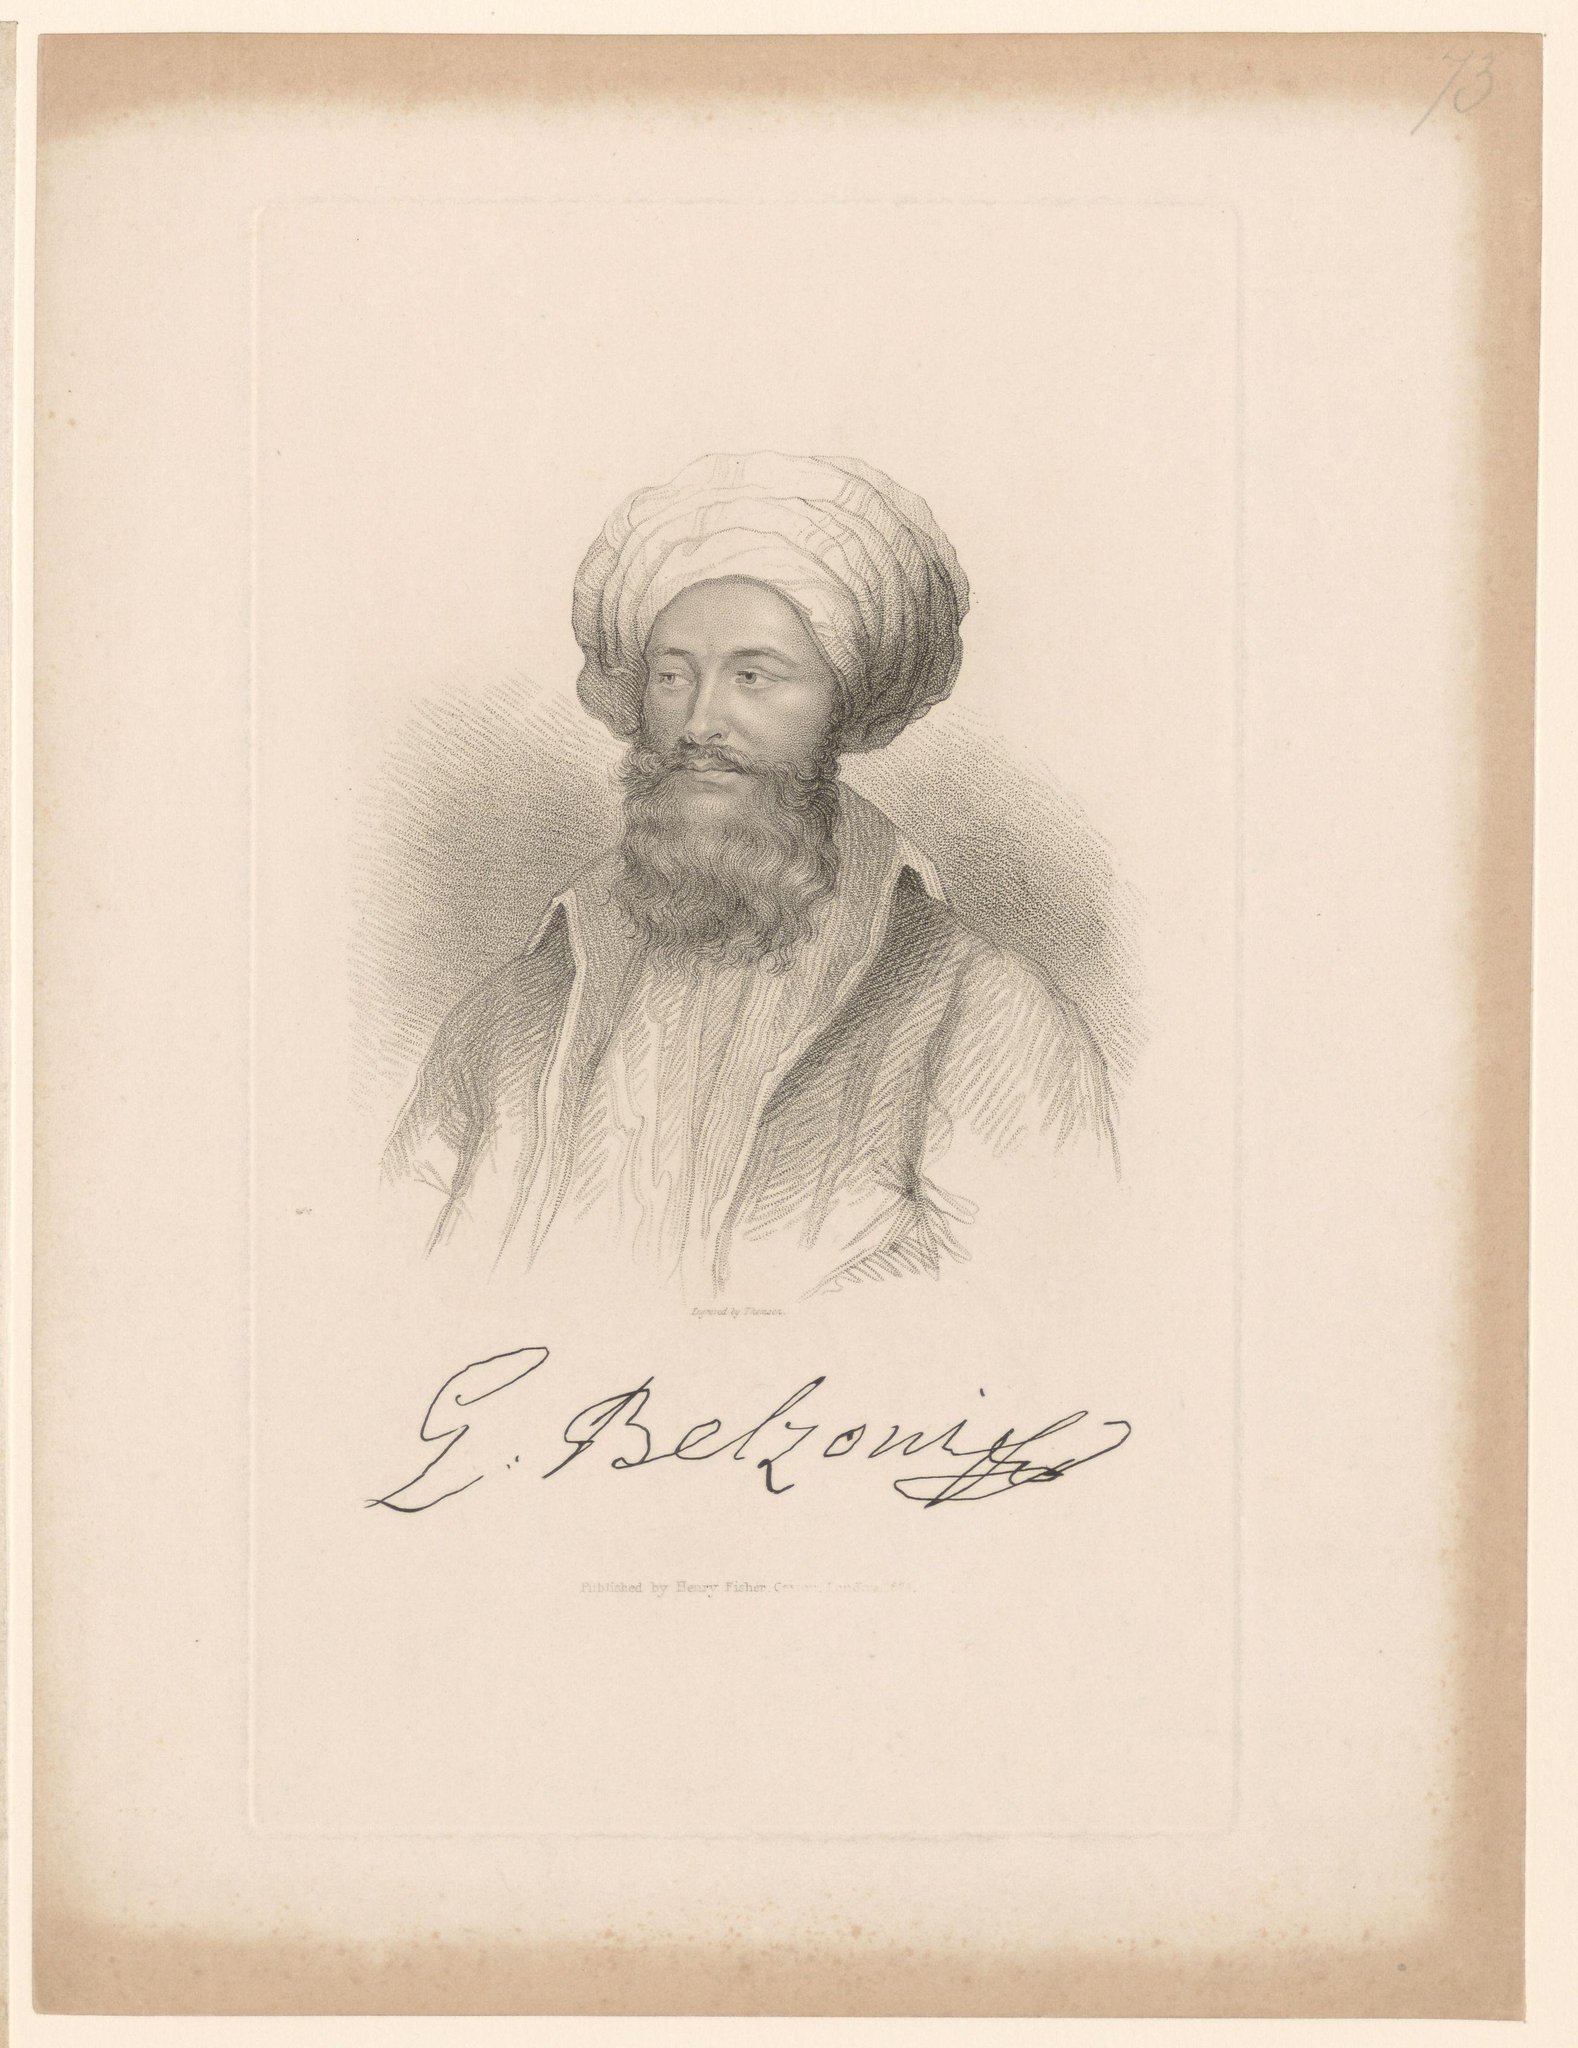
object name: print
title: Portret van Giovanni Battista Belzoni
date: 1824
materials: paper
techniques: roulette, engraving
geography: london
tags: giovanni battista belzoni, explorer (+ portrait of scholar, scientist), historical persons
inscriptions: collector's mark: Lugt 2228